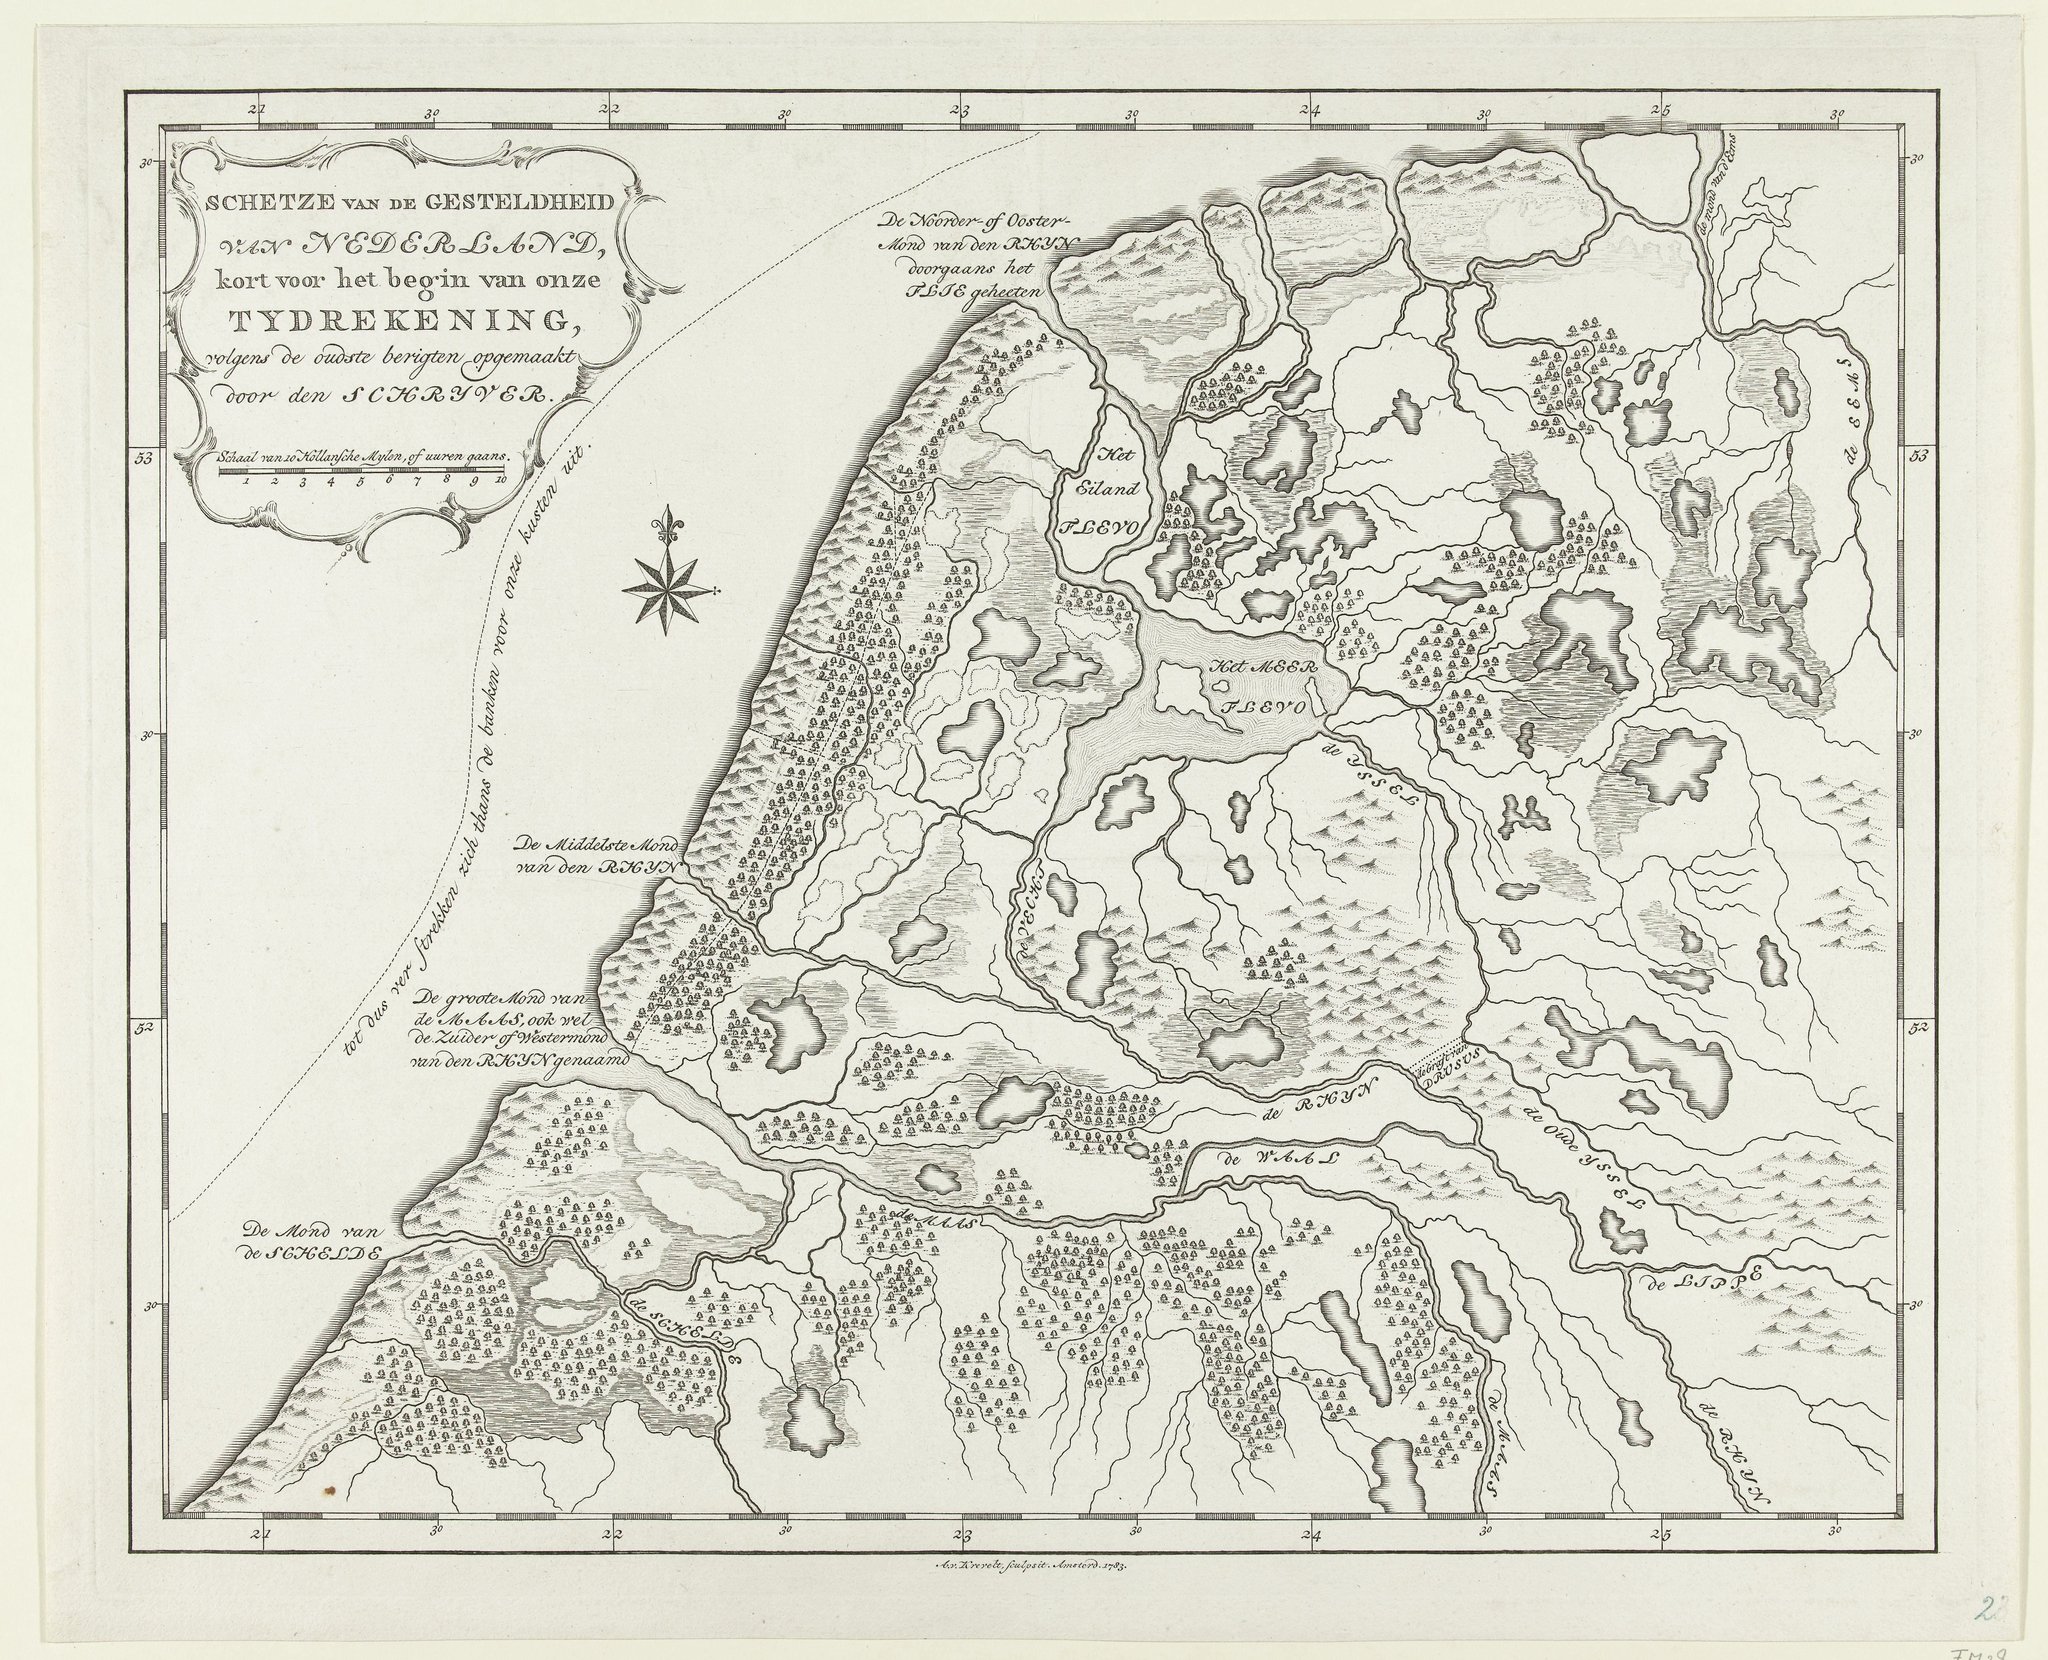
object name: print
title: Historische kaart van Nederland aan het begin van de jaartelling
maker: abraham van krevelt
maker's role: print maker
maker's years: 1732-1791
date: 1783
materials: paper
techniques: engraving, etching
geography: amsterdam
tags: maps of separate countries or regions, netherlands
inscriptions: date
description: Historische kaart van Nederland aan het begin van de jaartelling. Afkomstig uit E.M. Engelberts, De aloude staat en geschiedenissen der Vereenigde Nederlanden, bij Johannes Allart, Amsterdam 1784-1799.